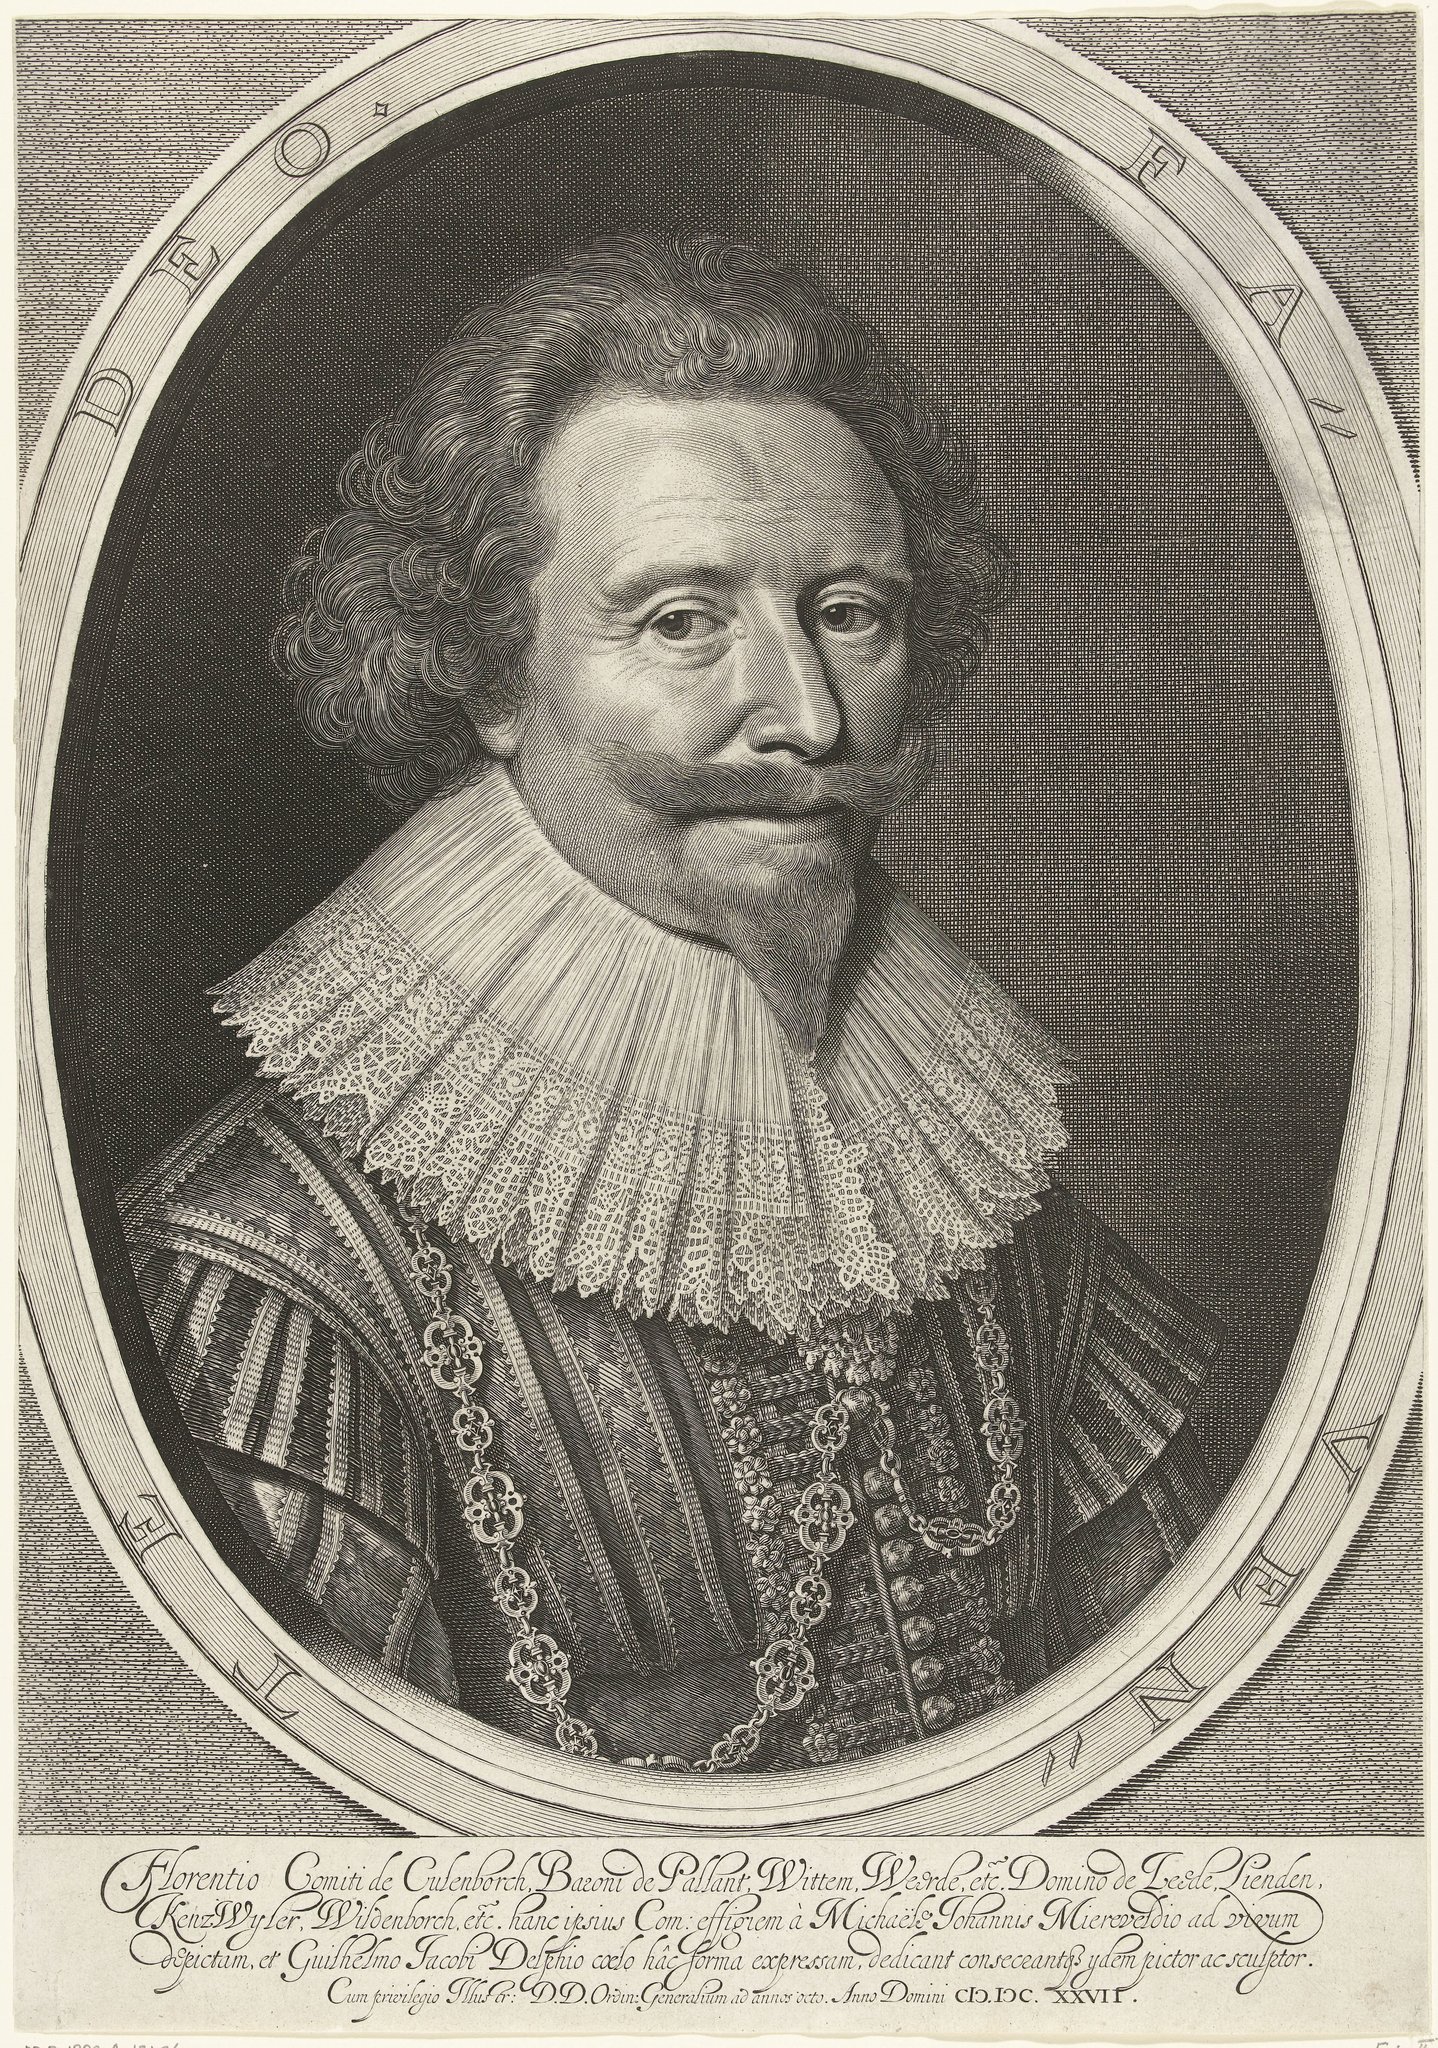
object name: print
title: Portret van Floris II, graaf van Pallandt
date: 1627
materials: paper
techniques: engraving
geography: delft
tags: floris ii van pallandt (graaf van culemborg), historical persons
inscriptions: collector's mark: Lugt 2228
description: Portret van Floris II, graaf van Pallandt, borststuk met plooikraag en keten in ovale omlijsting met Latijns motto. In ondermarge vier regels Latijns opschrift.